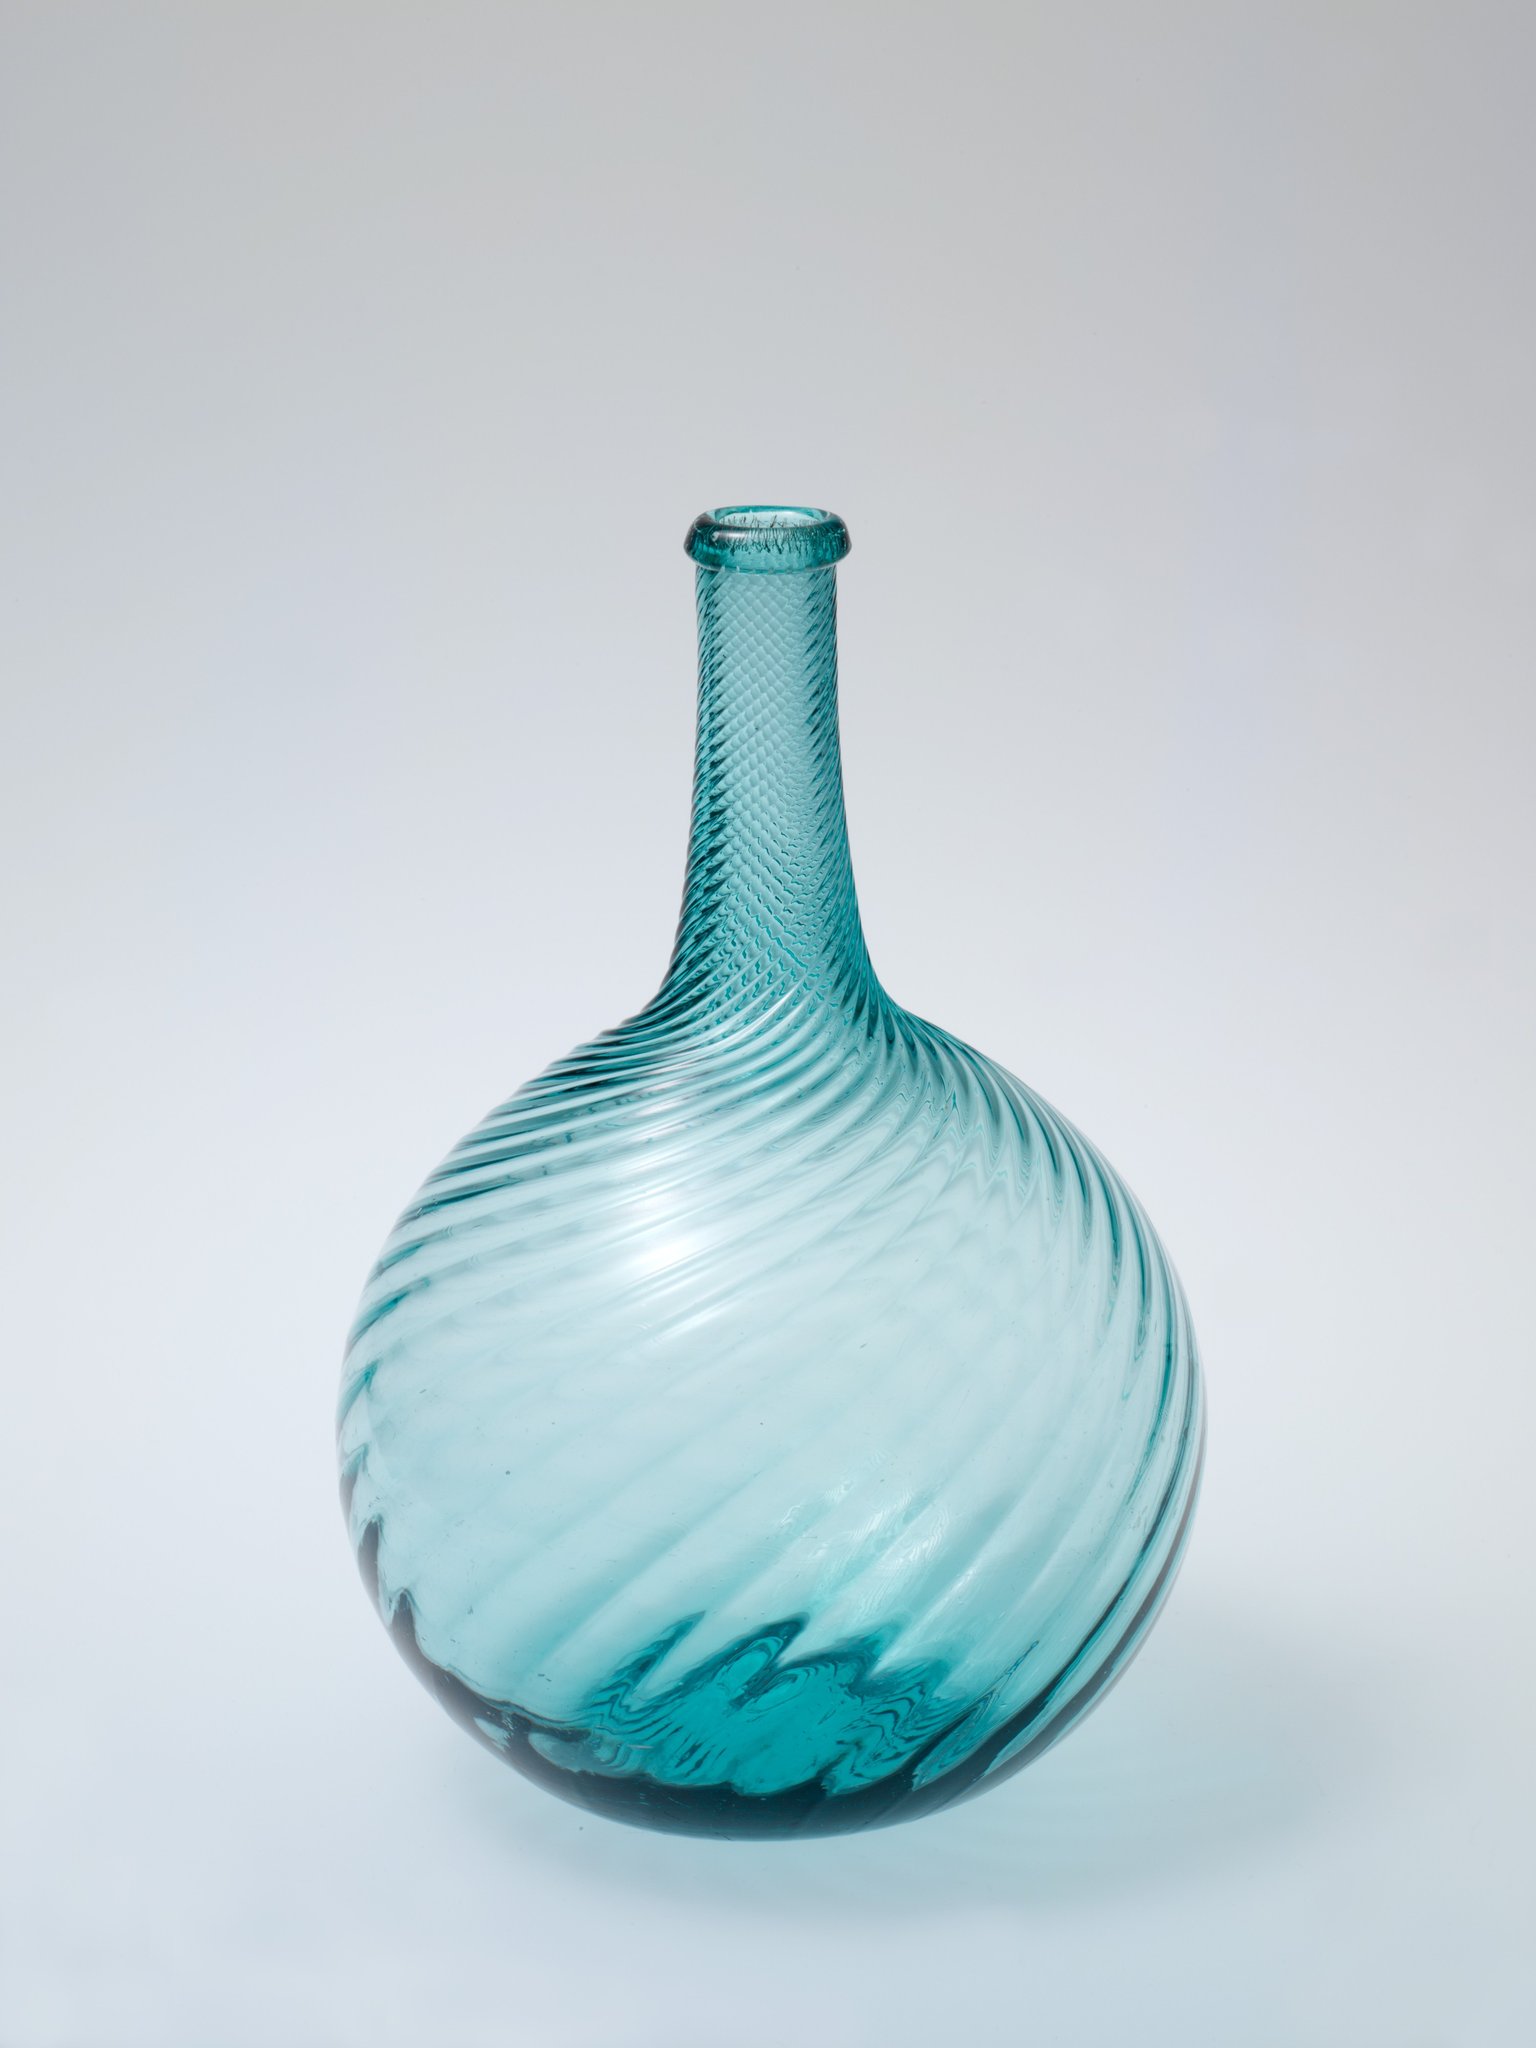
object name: bottle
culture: american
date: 1815-1845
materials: glass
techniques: glassblowing, molding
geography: united states